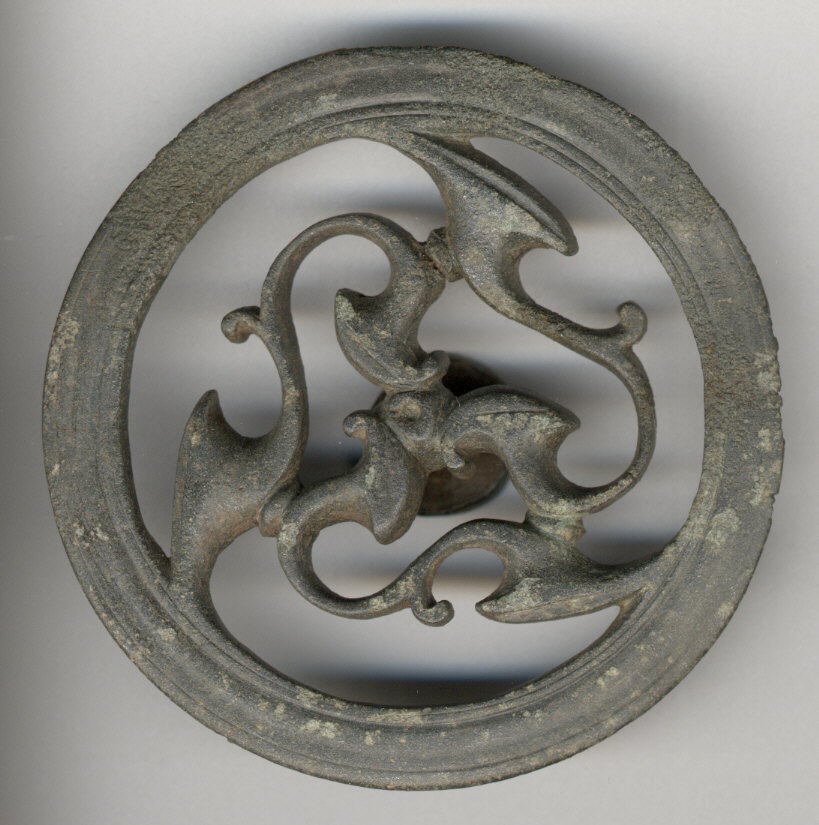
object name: mount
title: Openwork Mount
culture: celtic or roman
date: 100-300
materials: copper alloy